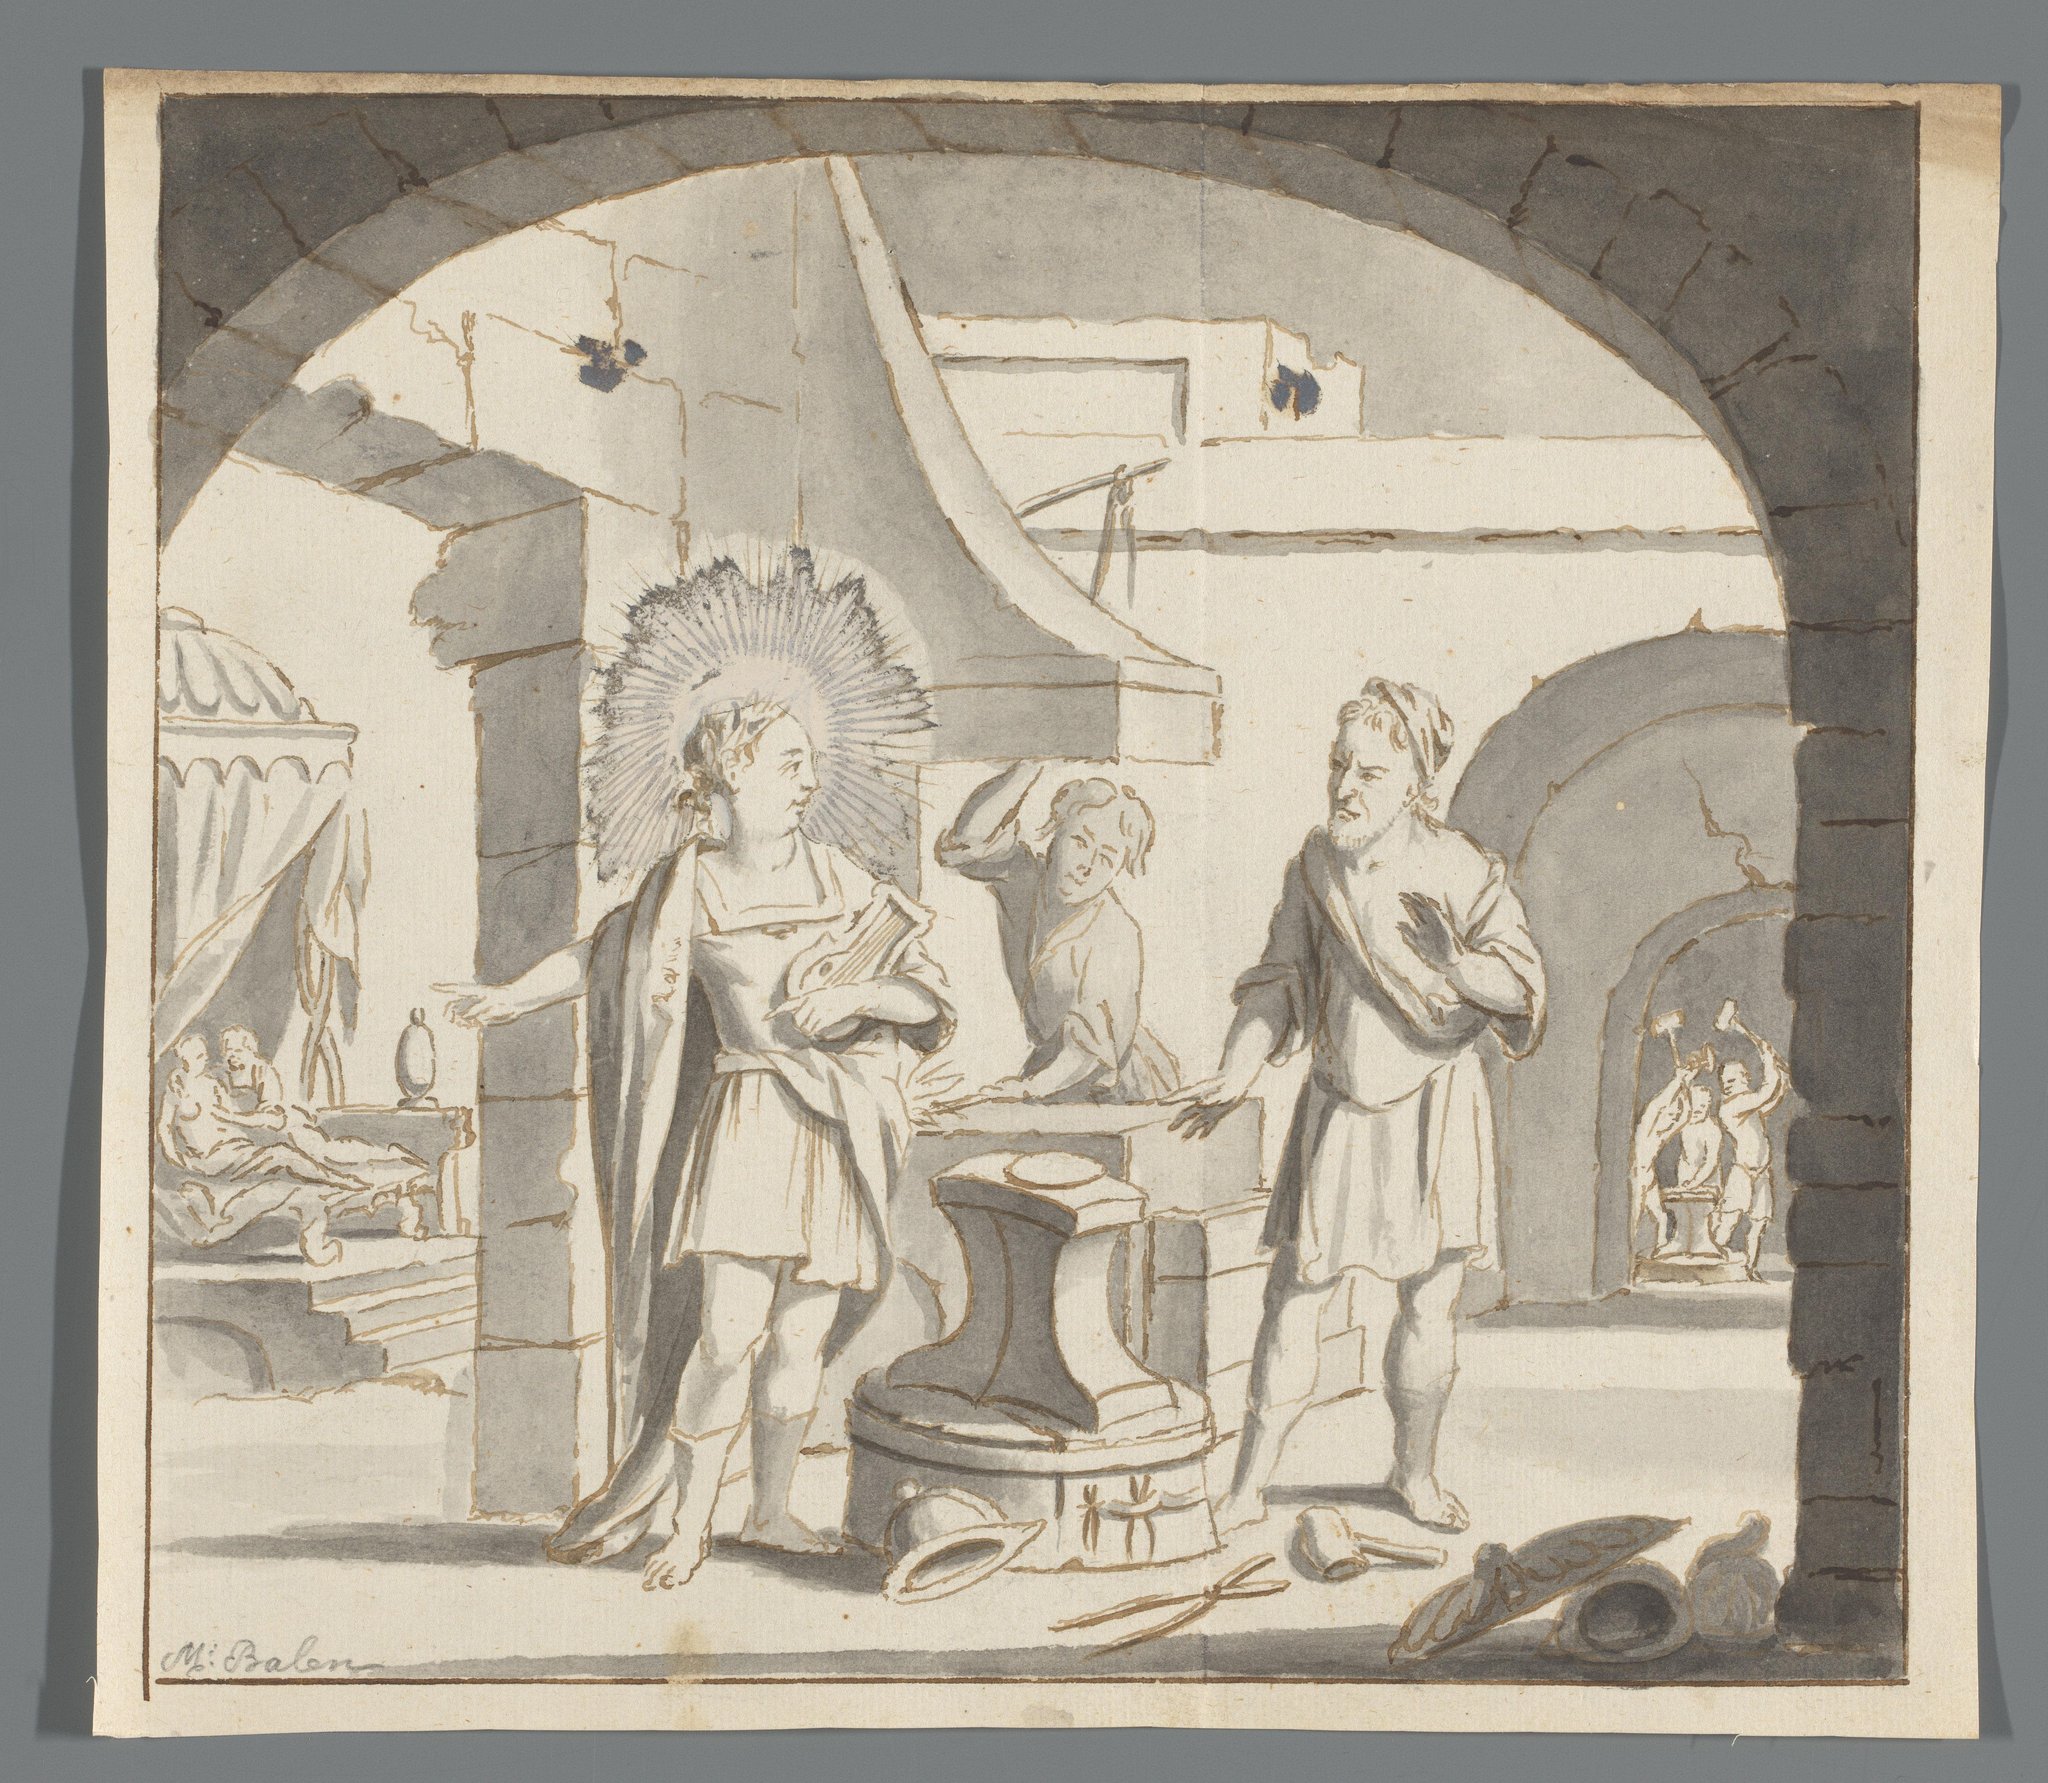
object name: drawing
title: Apollo brengt Vulcanus op de hoogte van het overspel van Venus met Mars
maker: matthijs balen (1684-1766)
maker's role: draughtsman, painter, print maker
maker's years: 1684-1766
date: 1694-1766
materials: paint, paper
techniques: brush, pen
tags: apollo in vulcan's forge revealing venus' love-affair with mars